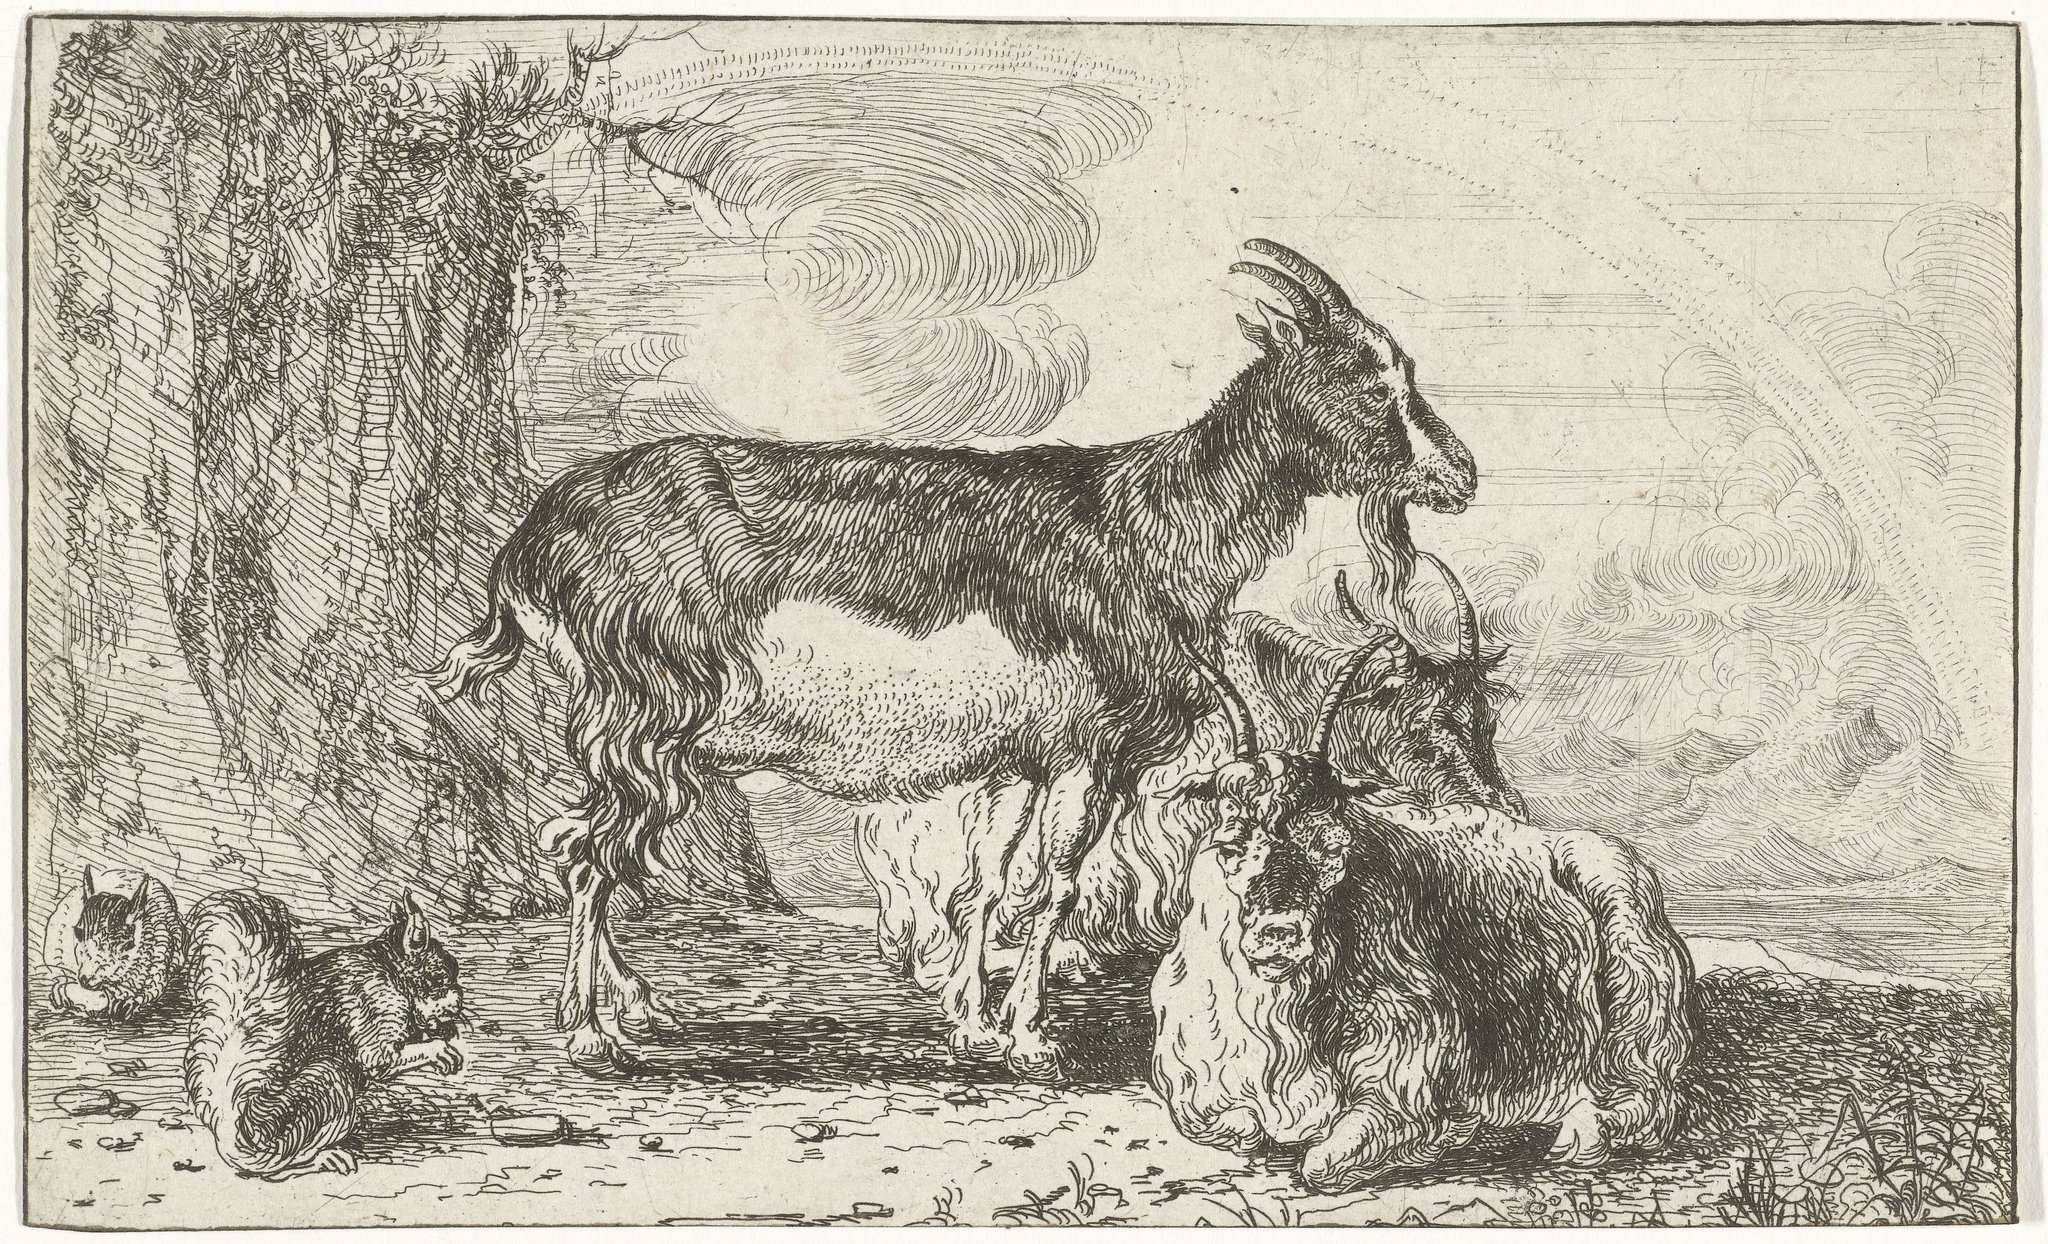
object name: print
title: Geiten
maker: jan van den hecke (i)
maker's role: print maker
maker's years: 1619-1684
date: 1656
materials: paper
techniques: etching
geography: brussels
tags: goat, rodents: squirrel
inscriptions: collector's mark: Lugt 240